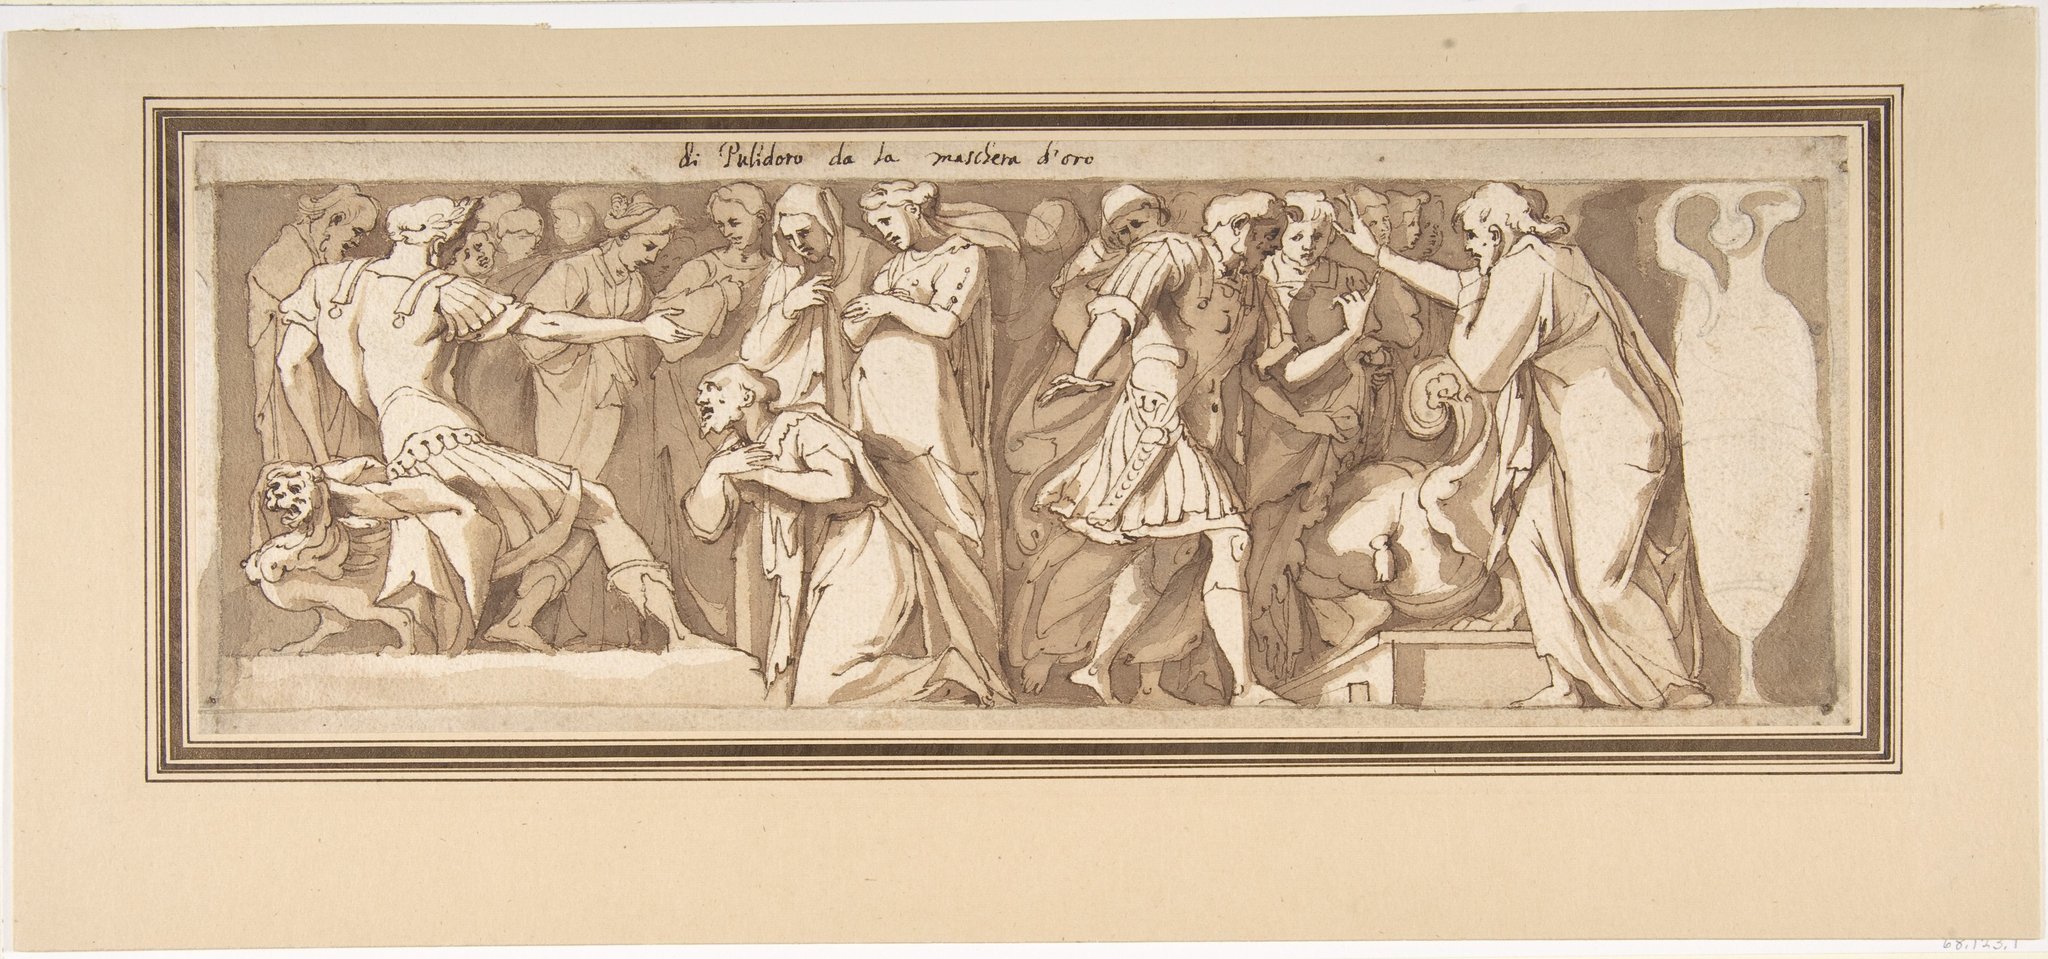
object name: drawing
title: Scenes from Ancient History, after Polidoro da Caravaggio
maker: andrea boscoli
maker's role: artist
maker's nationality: italian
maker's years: 1560-1608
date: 1560-1608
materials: chalk, ink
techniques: brush, pen, wash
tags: soldiers,men,women